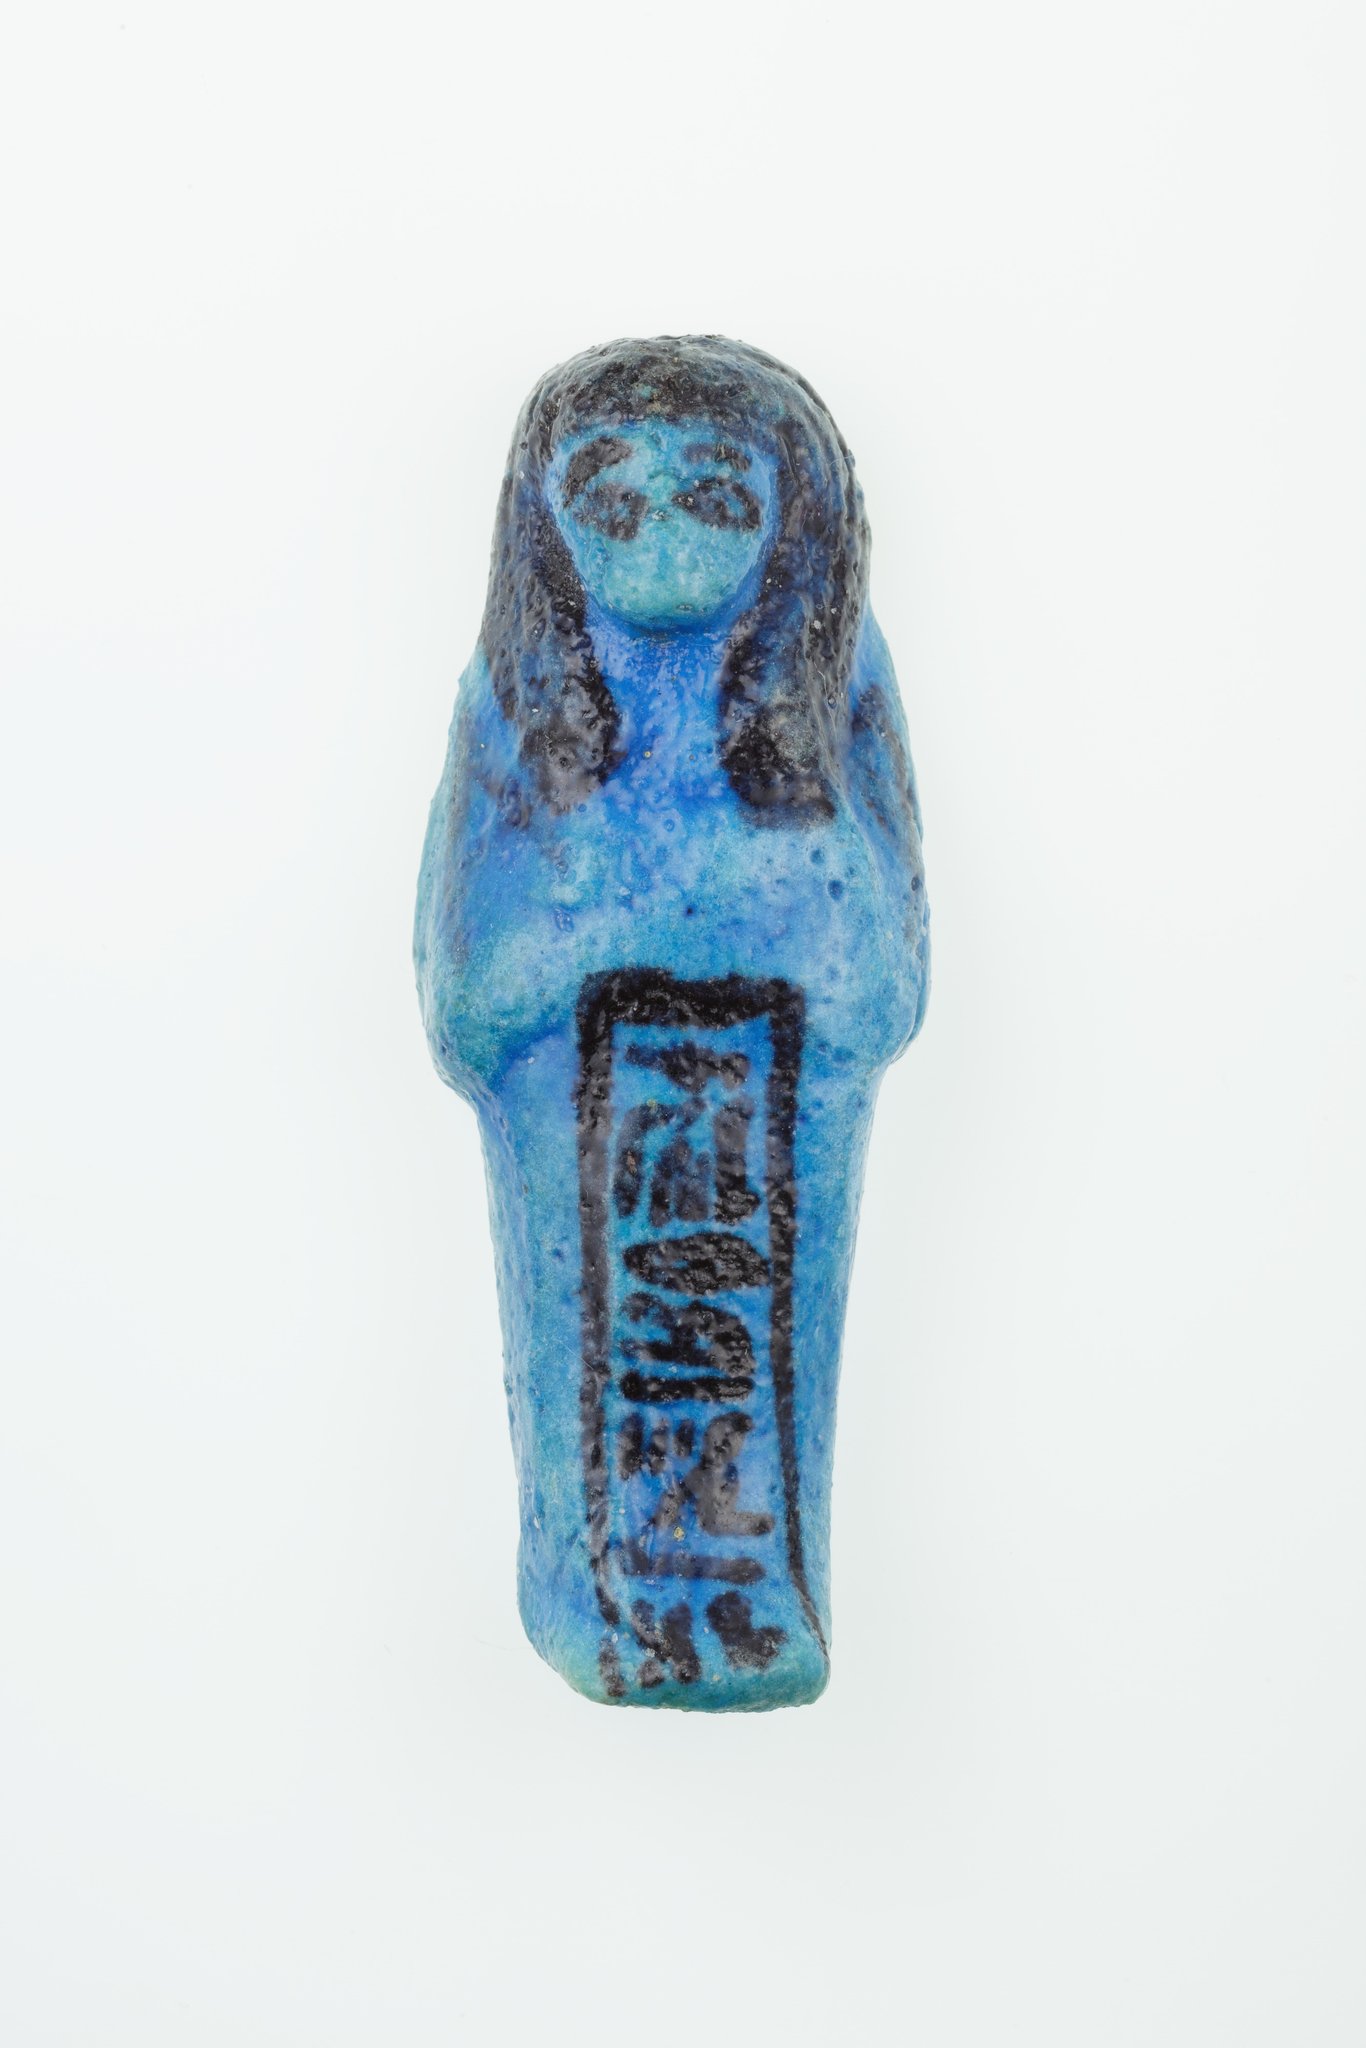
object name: shabti, worker, nauny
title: Worker Shabti of Nauny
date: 1050 BCE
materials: faience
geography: egypt